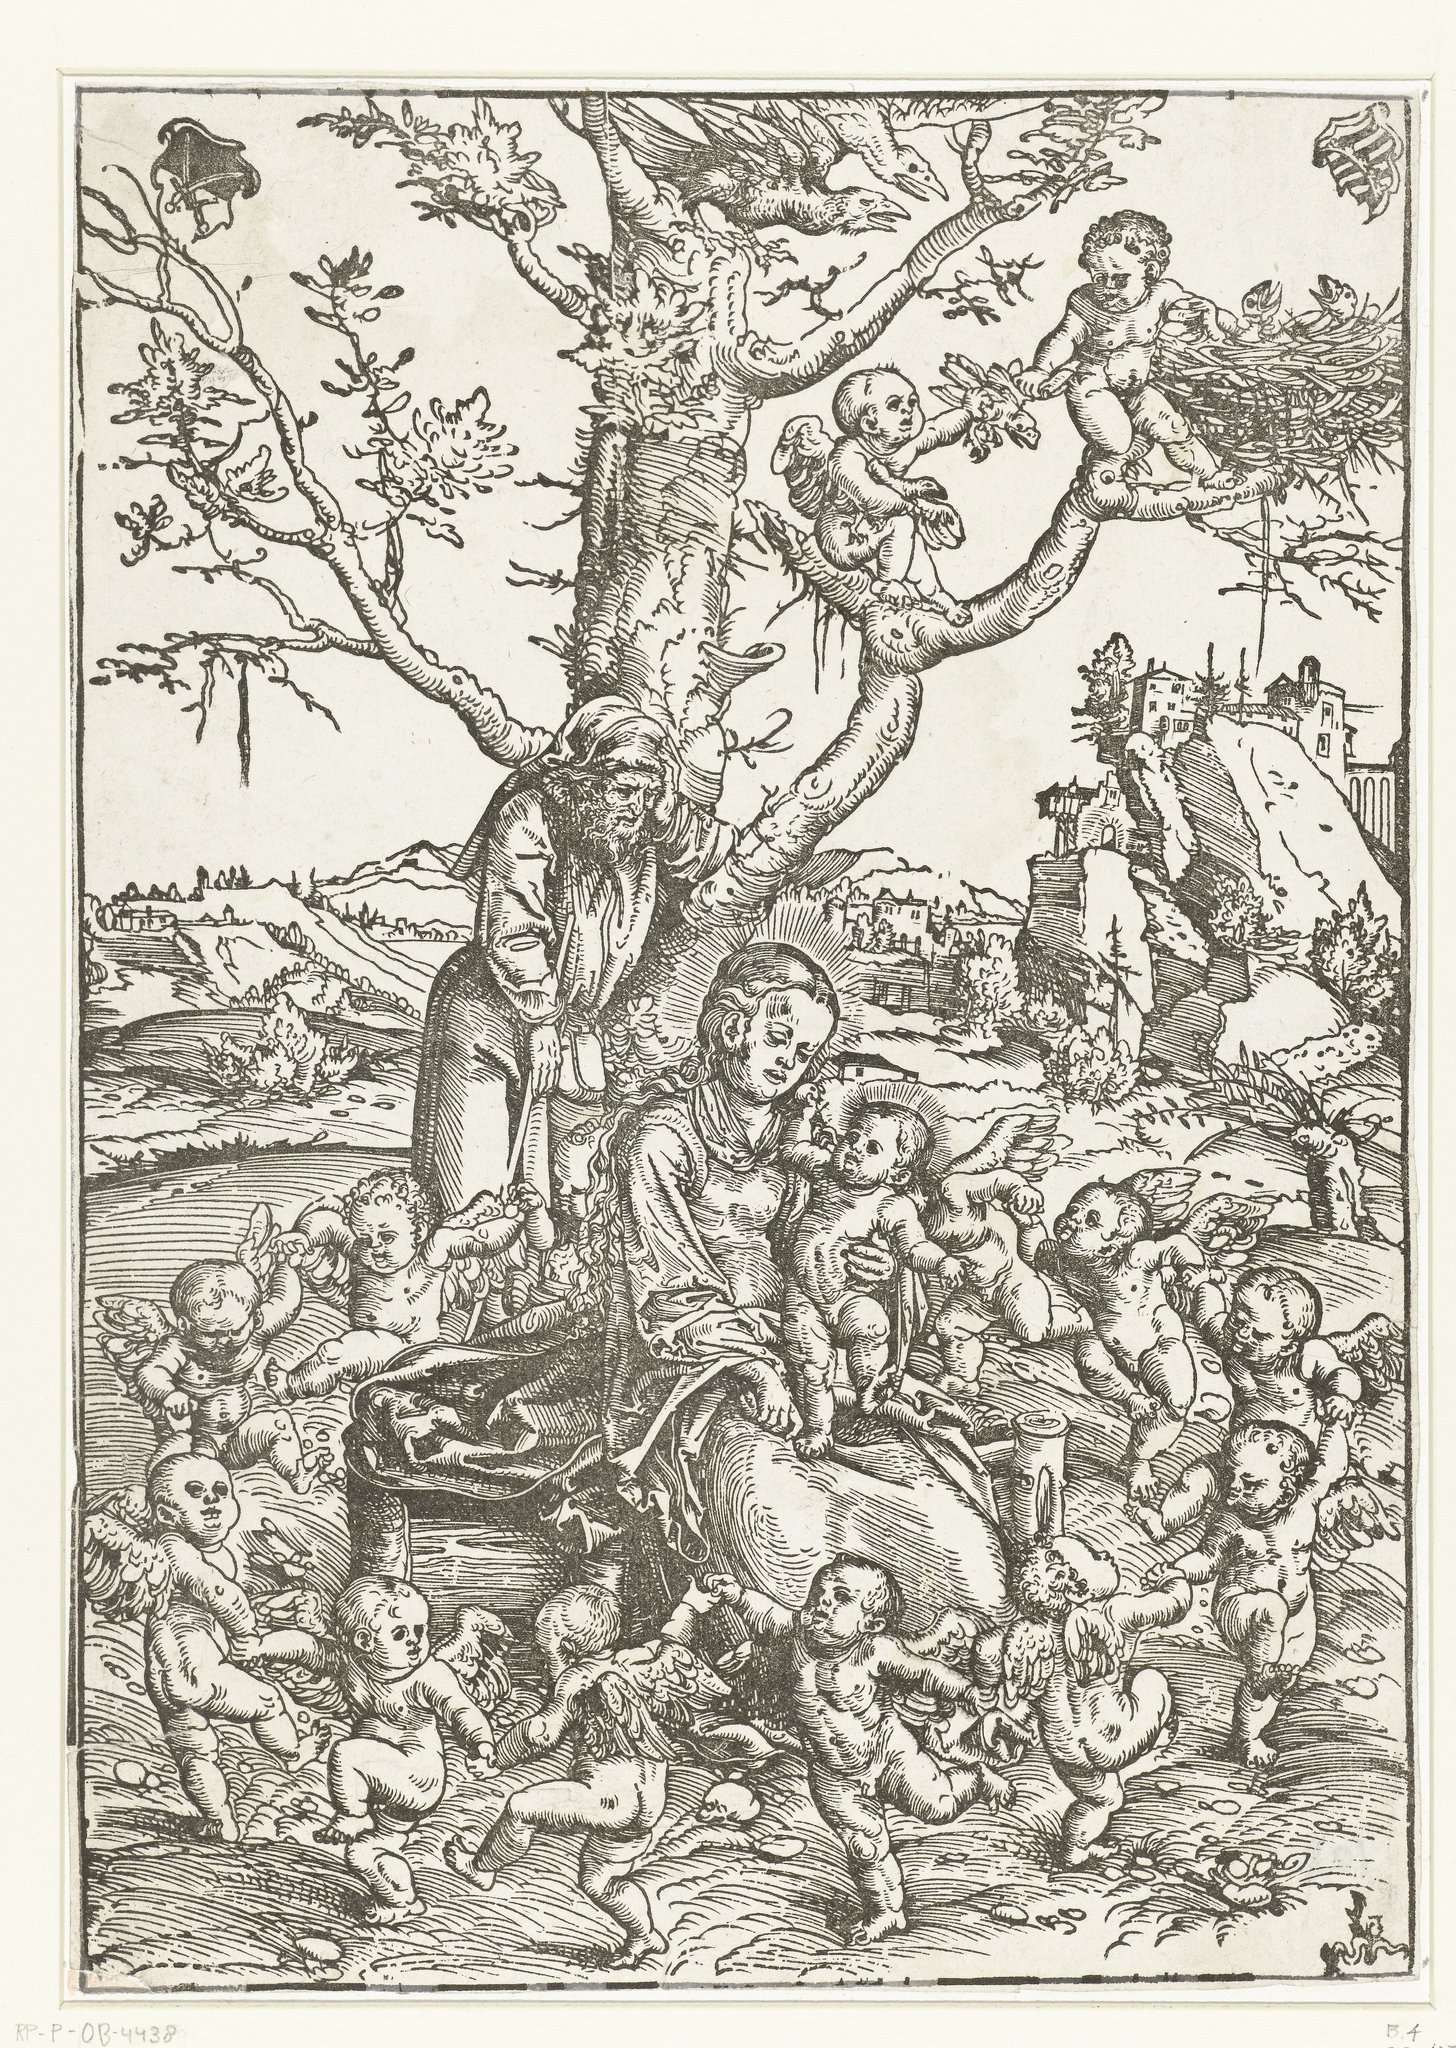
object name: print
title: Rest on the Flight into Egypt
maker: lucas cranach (i)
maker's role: draughtsman, print maker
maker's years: 1472-1553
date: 1509-1510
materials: paper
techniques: woodcut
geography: germany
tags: rest on the flight into egypt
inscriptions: collector's mark: Lugt 240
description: Maria zit met het kind op haar schoot bij een boom te rusten tijdens de vlucht naar Egypte. Jozef staat achter hen en leunt tegen de boomstam. Rond de zittende Maria en het Christuskind dansen putti. Twee putti zitten in de boom en vangen jonge kraaien uit een nest. Op de achtergrond is een bergachtig landschap weergegeven. Links- en rechtsboven zijn twee schilden met het keurvorstelijk en hertogelijk wapen van Saksen afgebeeld